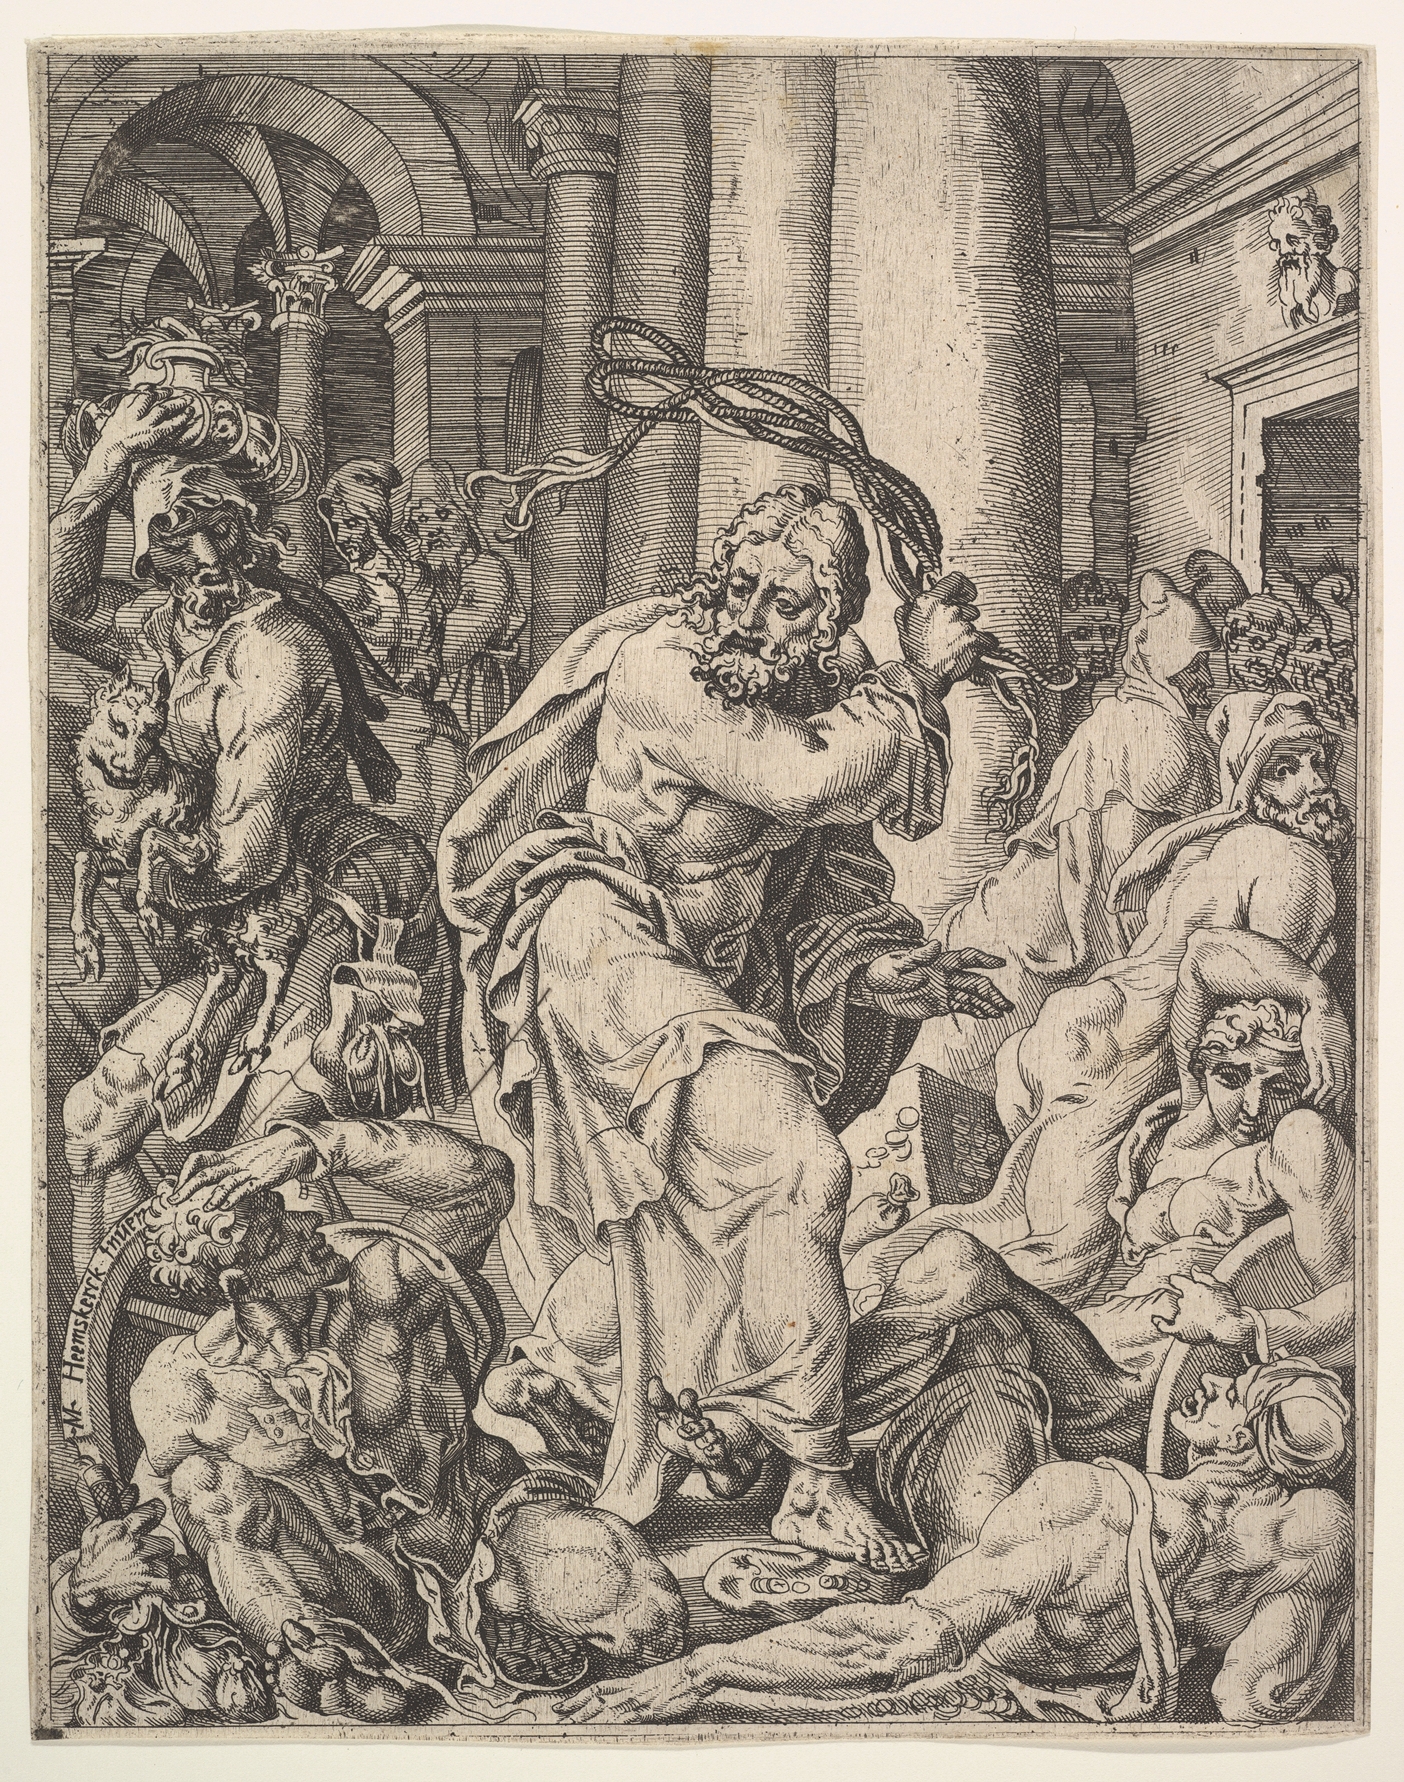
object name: print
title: Christ Driving the Money Changers from the Temple, from "The Fall and Salvation of Mankind through the Life and Passion of Christ"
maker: maarten van heemskerck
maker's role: artist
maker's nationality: netherlandish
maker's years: 1498-1574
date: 1548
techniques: etching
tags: christ,punishment